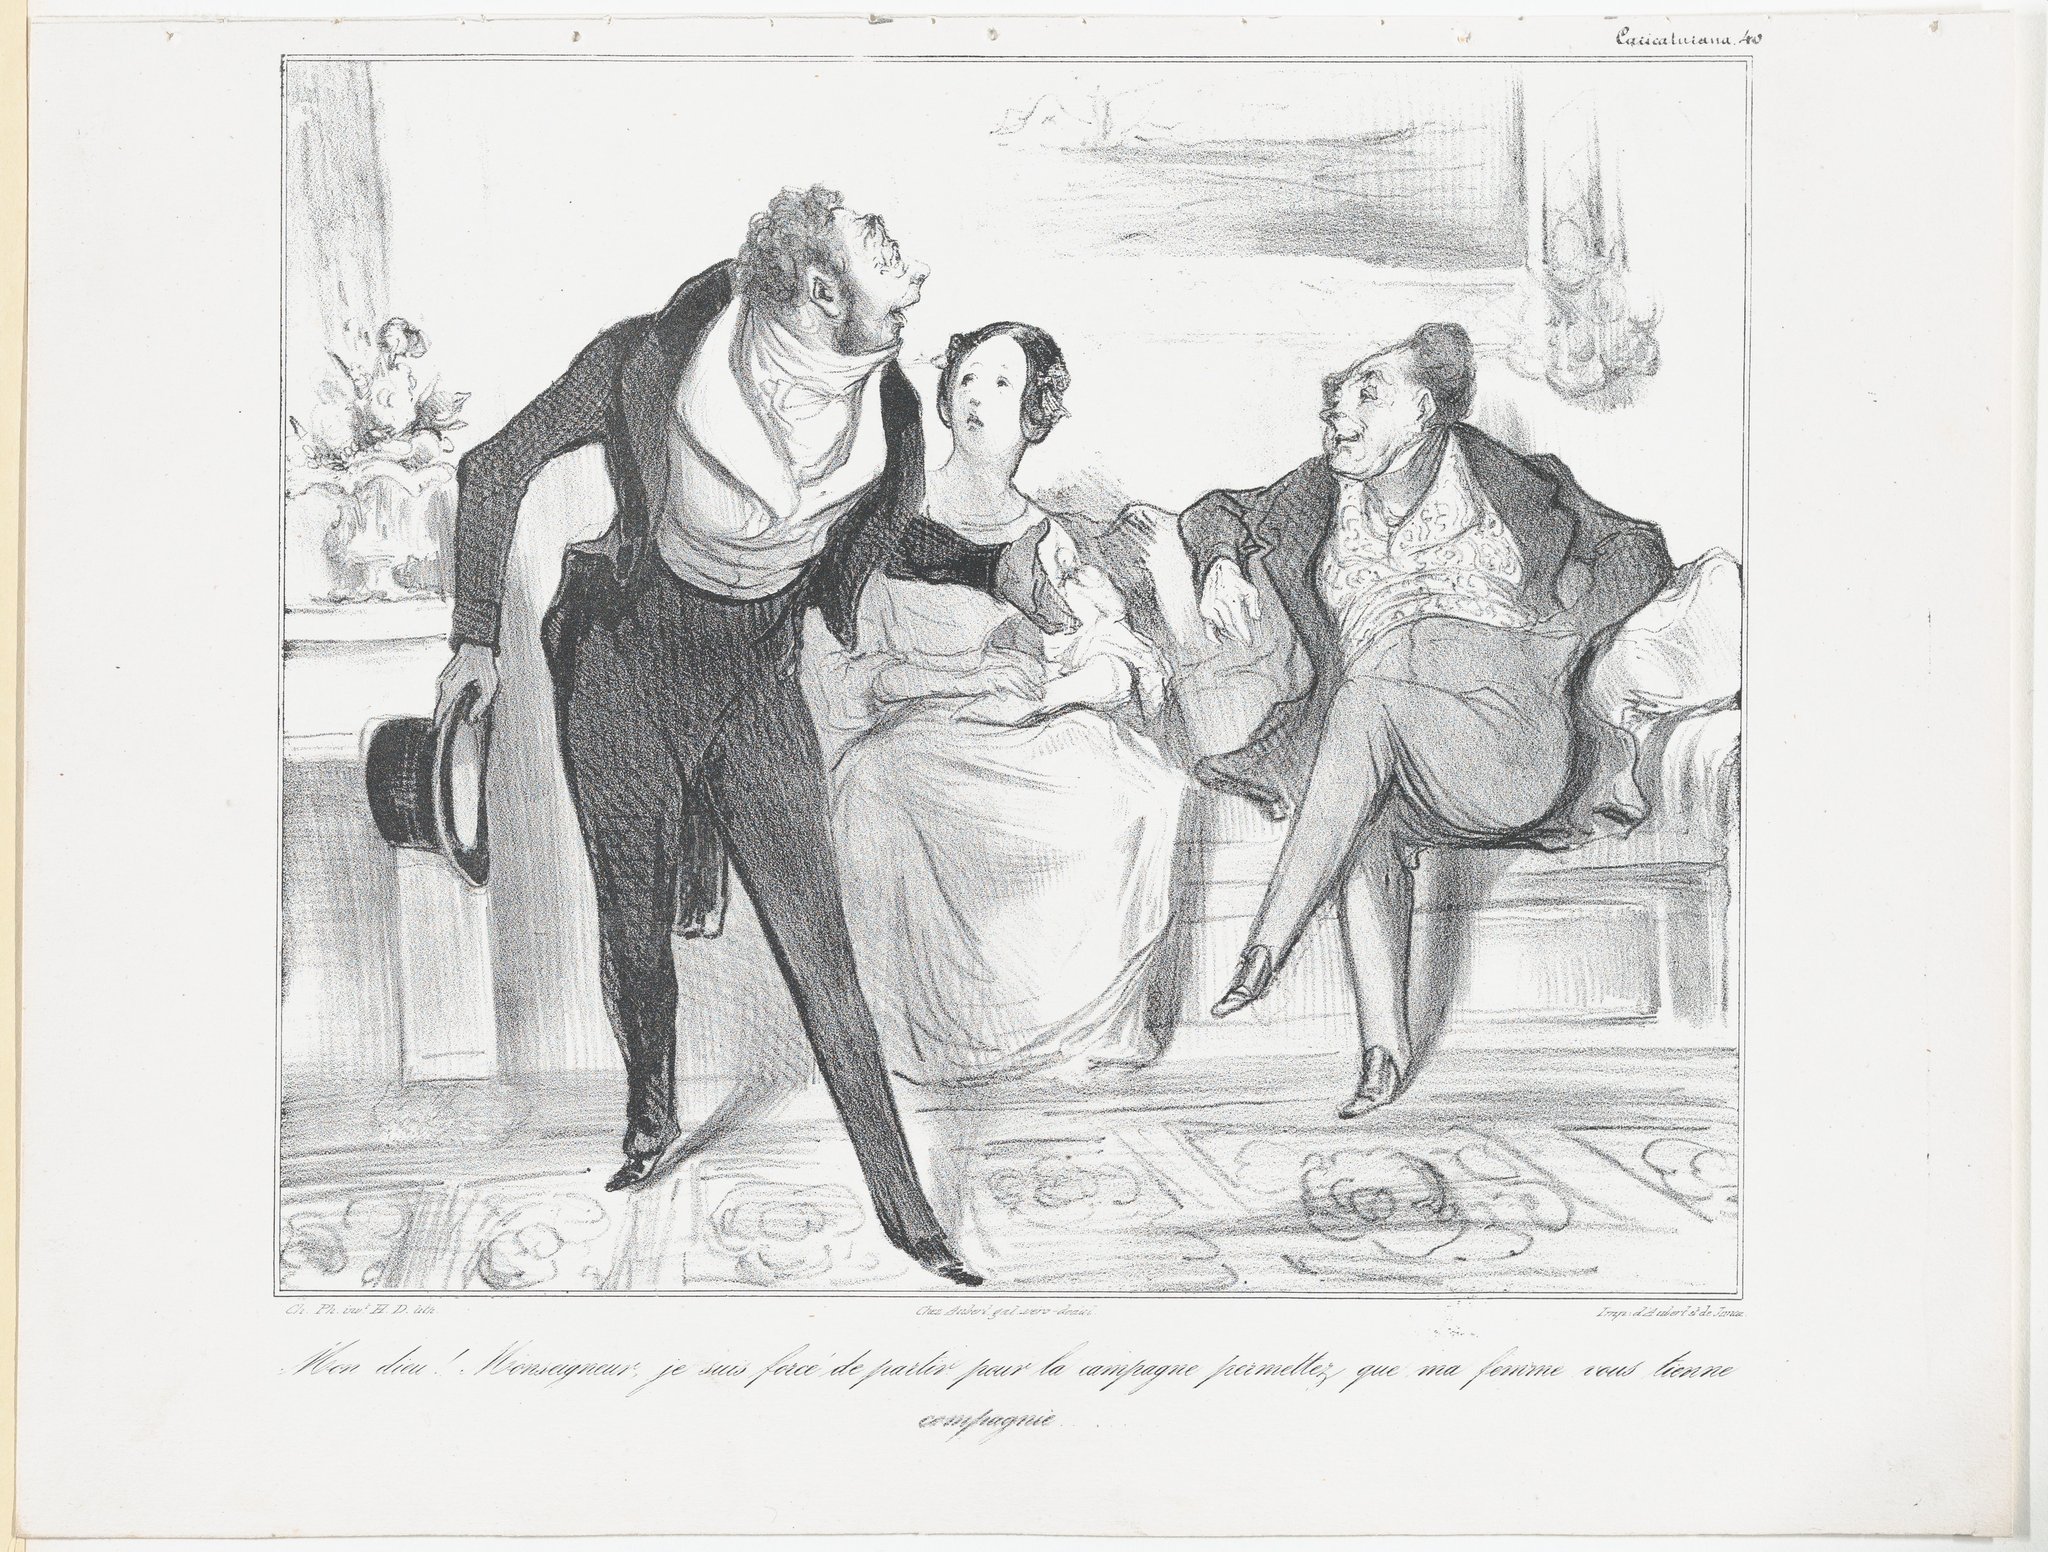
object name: print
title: Plate 40: My God! Monseigneur, I am forced to leave for the countryside, allow me to leave my wife behind to keep you company, from 'Caricaturana,' published in Les Robert Macaires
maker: honoré daumier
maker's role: artist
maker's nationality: french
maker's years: 1808-1879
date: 1838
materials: paper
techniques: lithograph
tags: satire,men,women